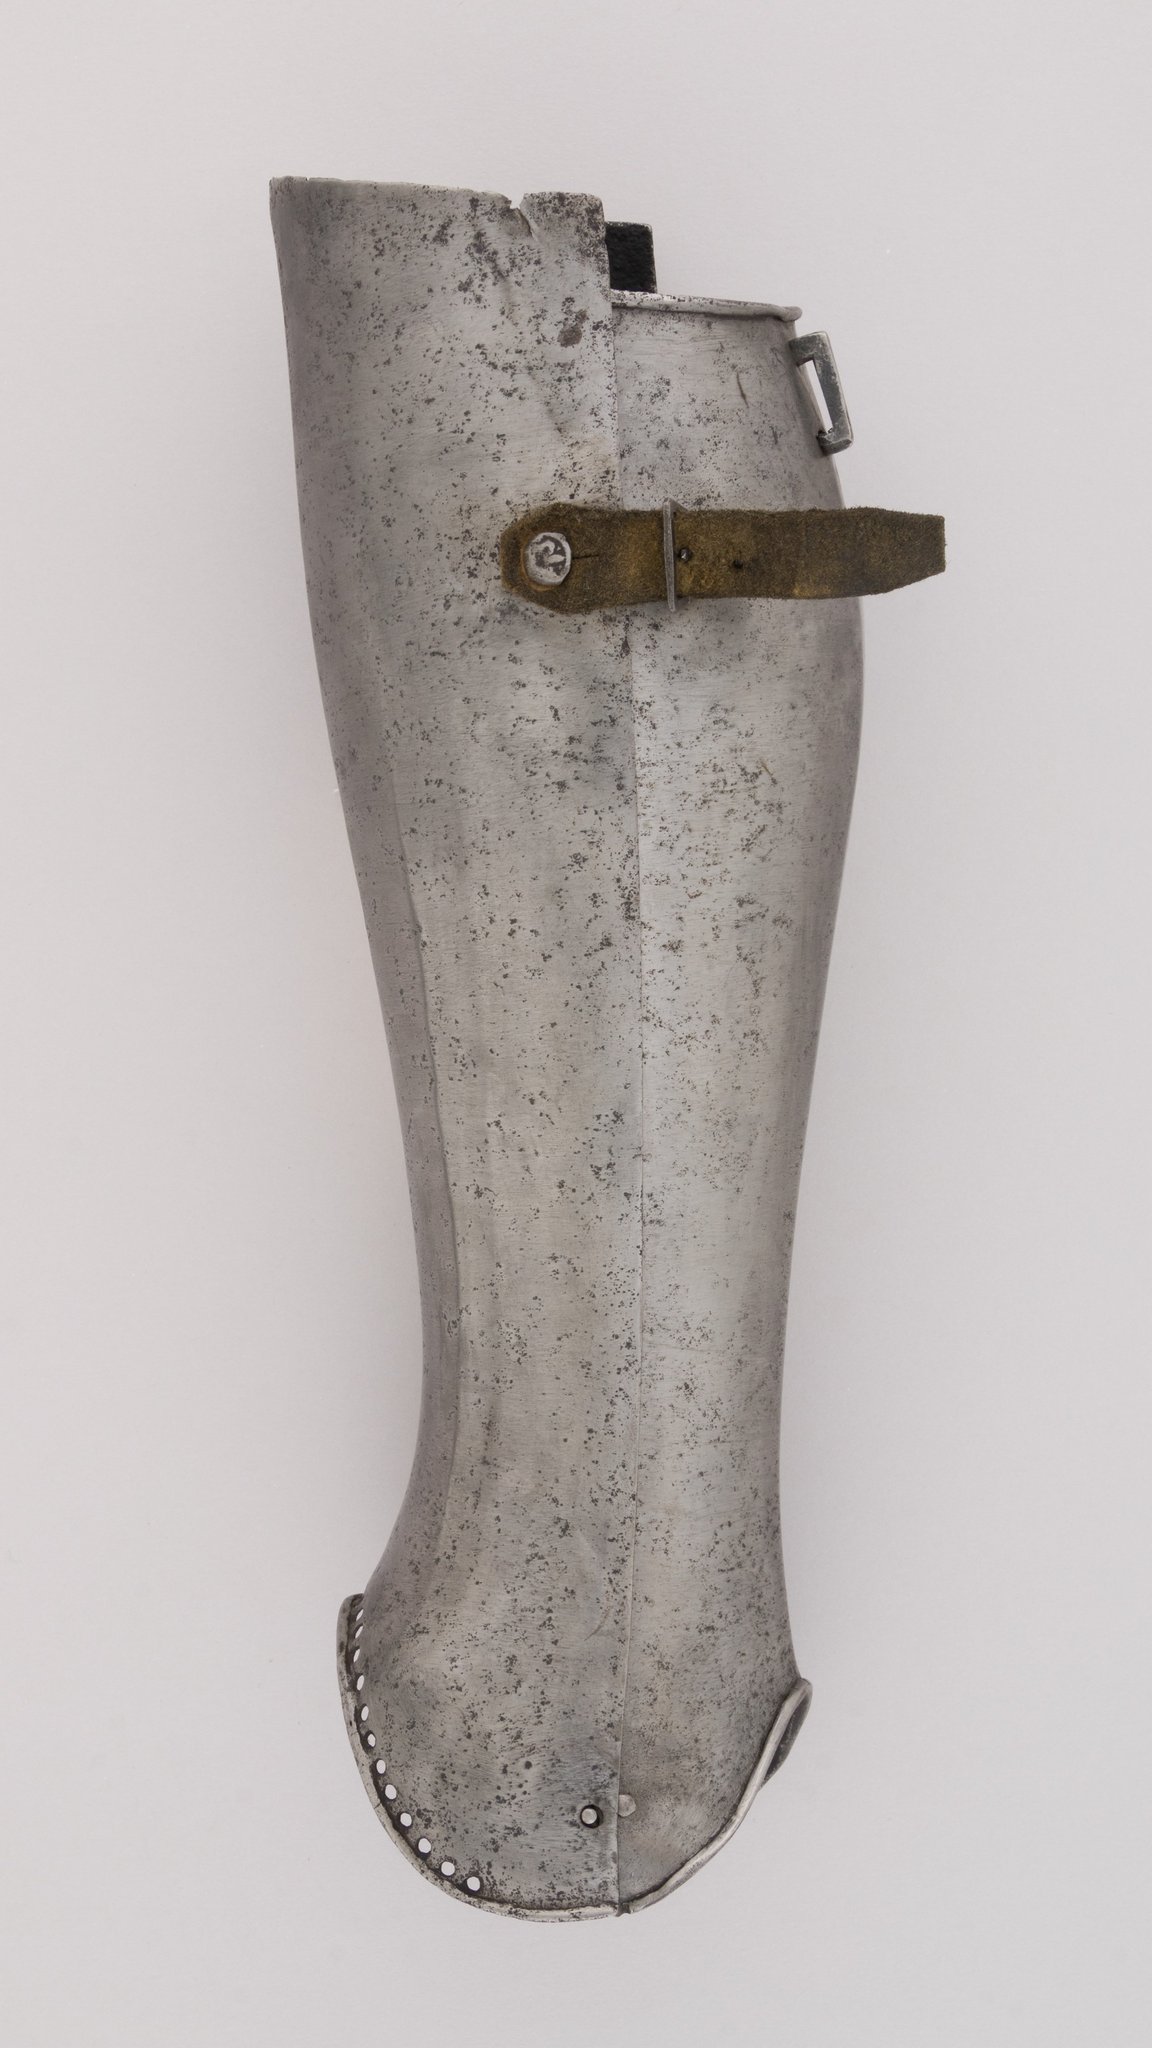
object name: pair of greave lower leg defense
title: Pair of Greaves (Lower Leg Defenses)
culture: italian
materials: leather, steel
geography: italy